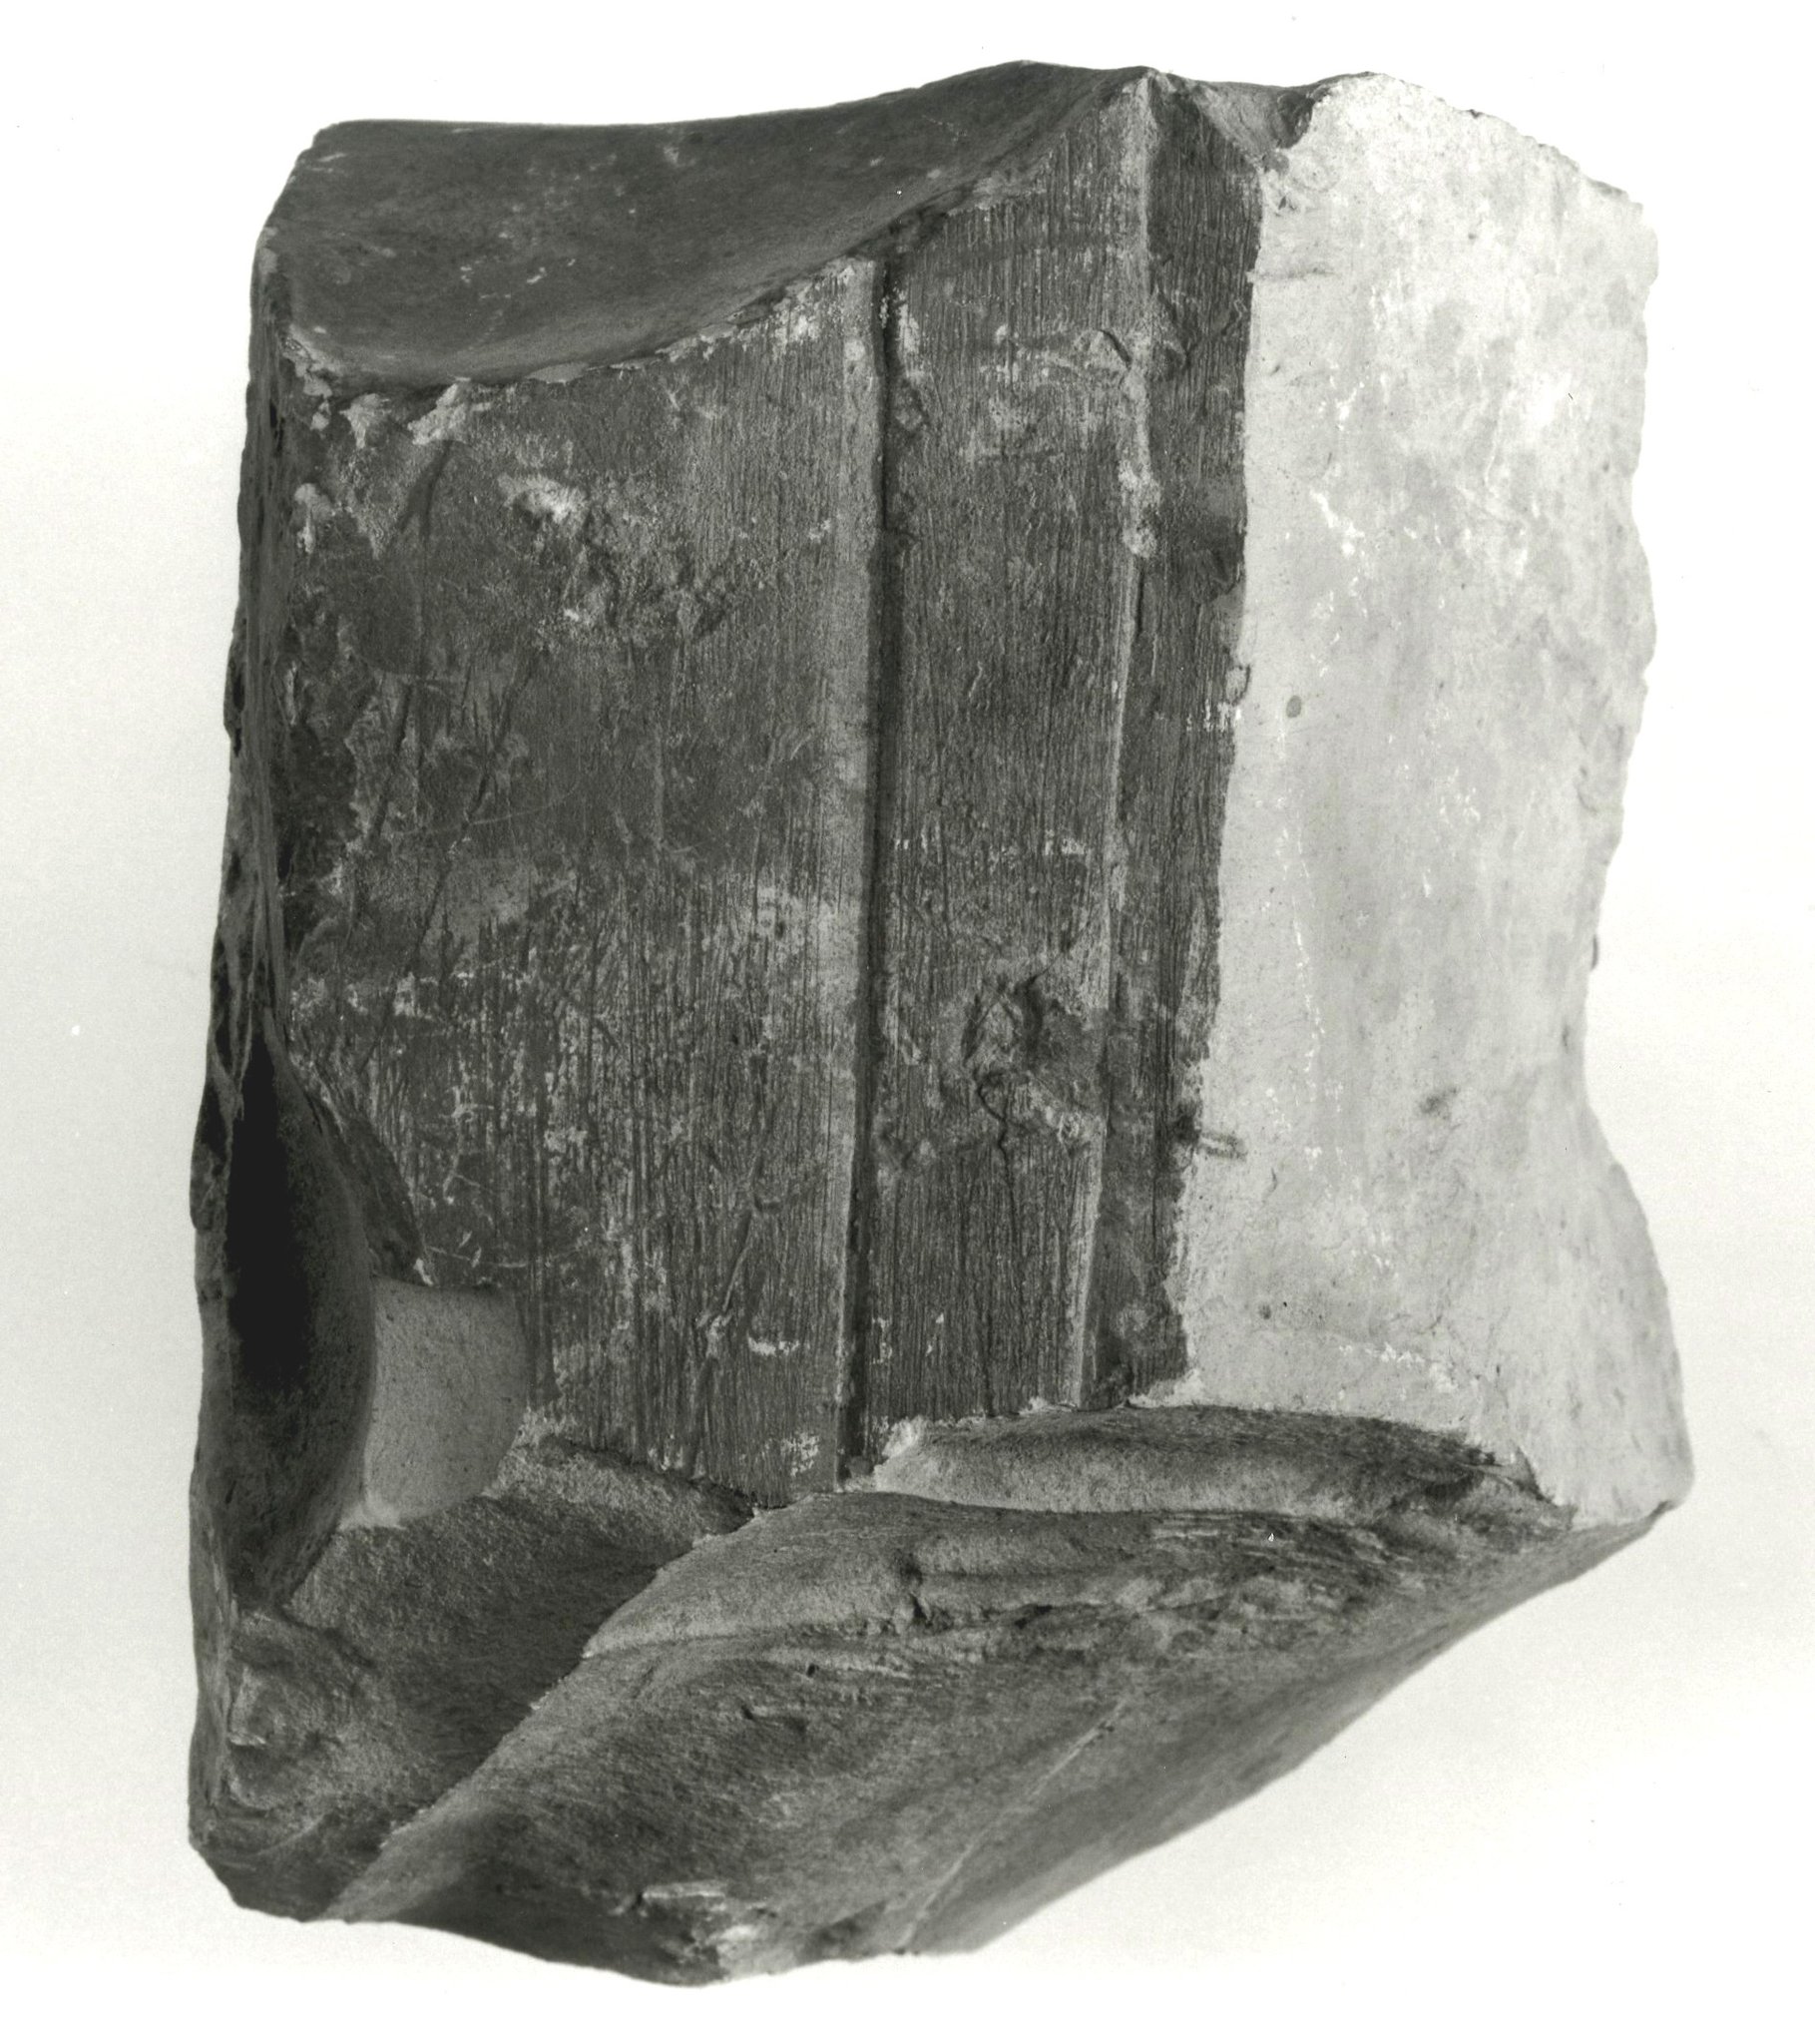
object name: relief, tomb of nespekashuty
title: Raised relief fragment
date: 664-610 BCE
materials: limestone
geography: egypt